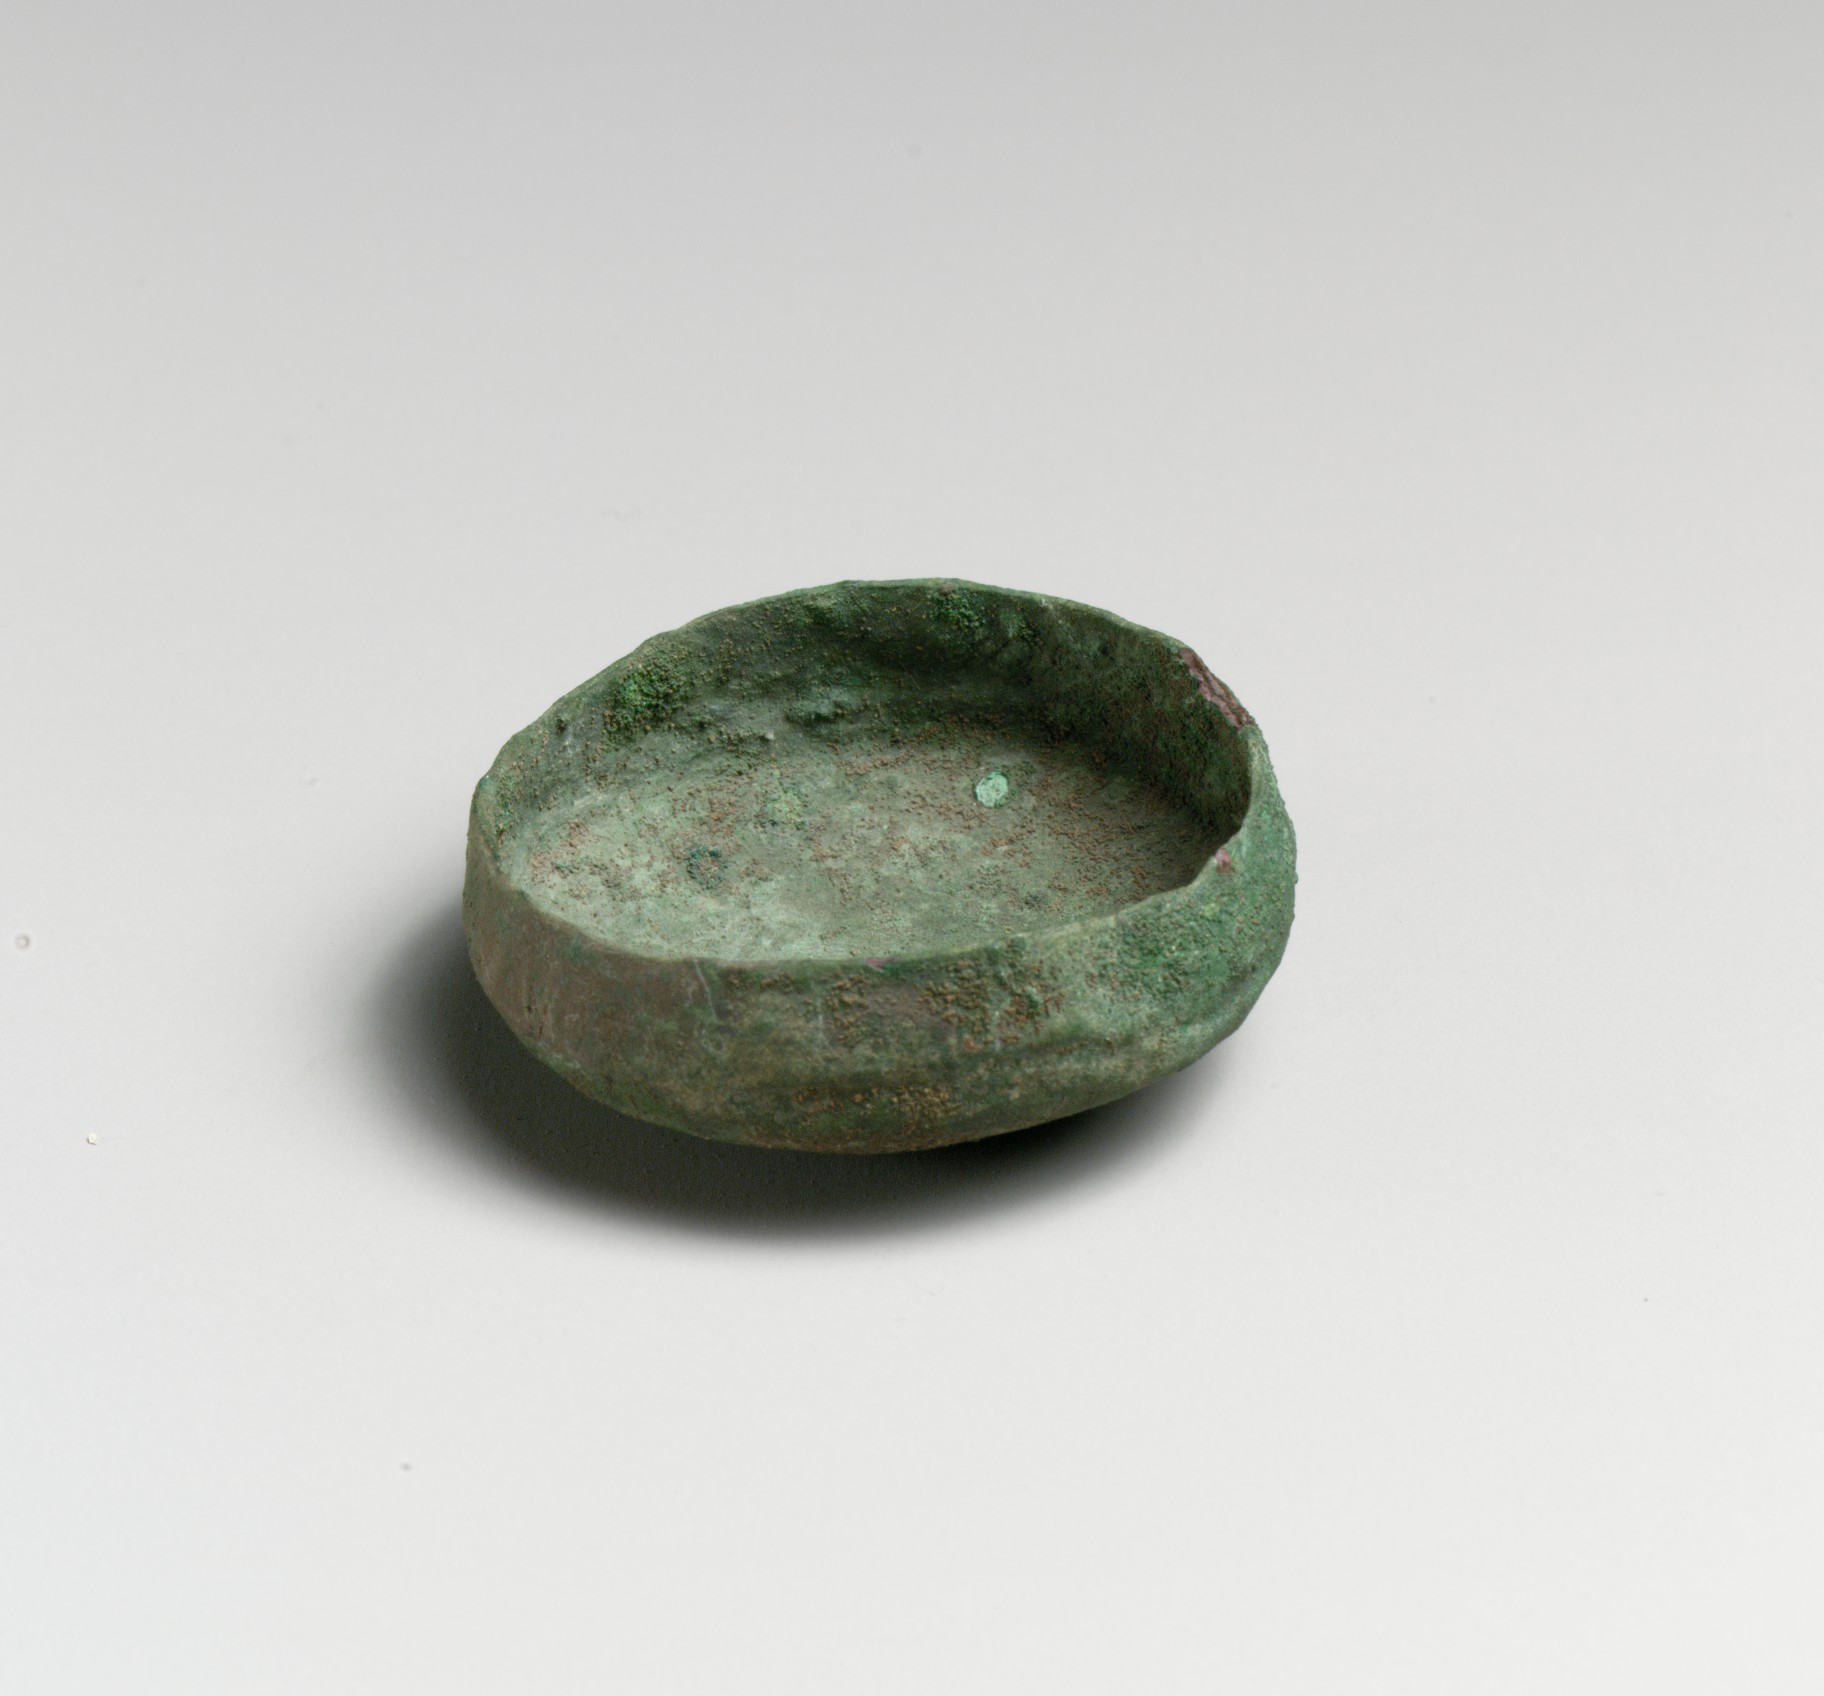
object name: lid or bos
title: Lid or Boss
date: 7000 BCE-330 CE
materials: bronze